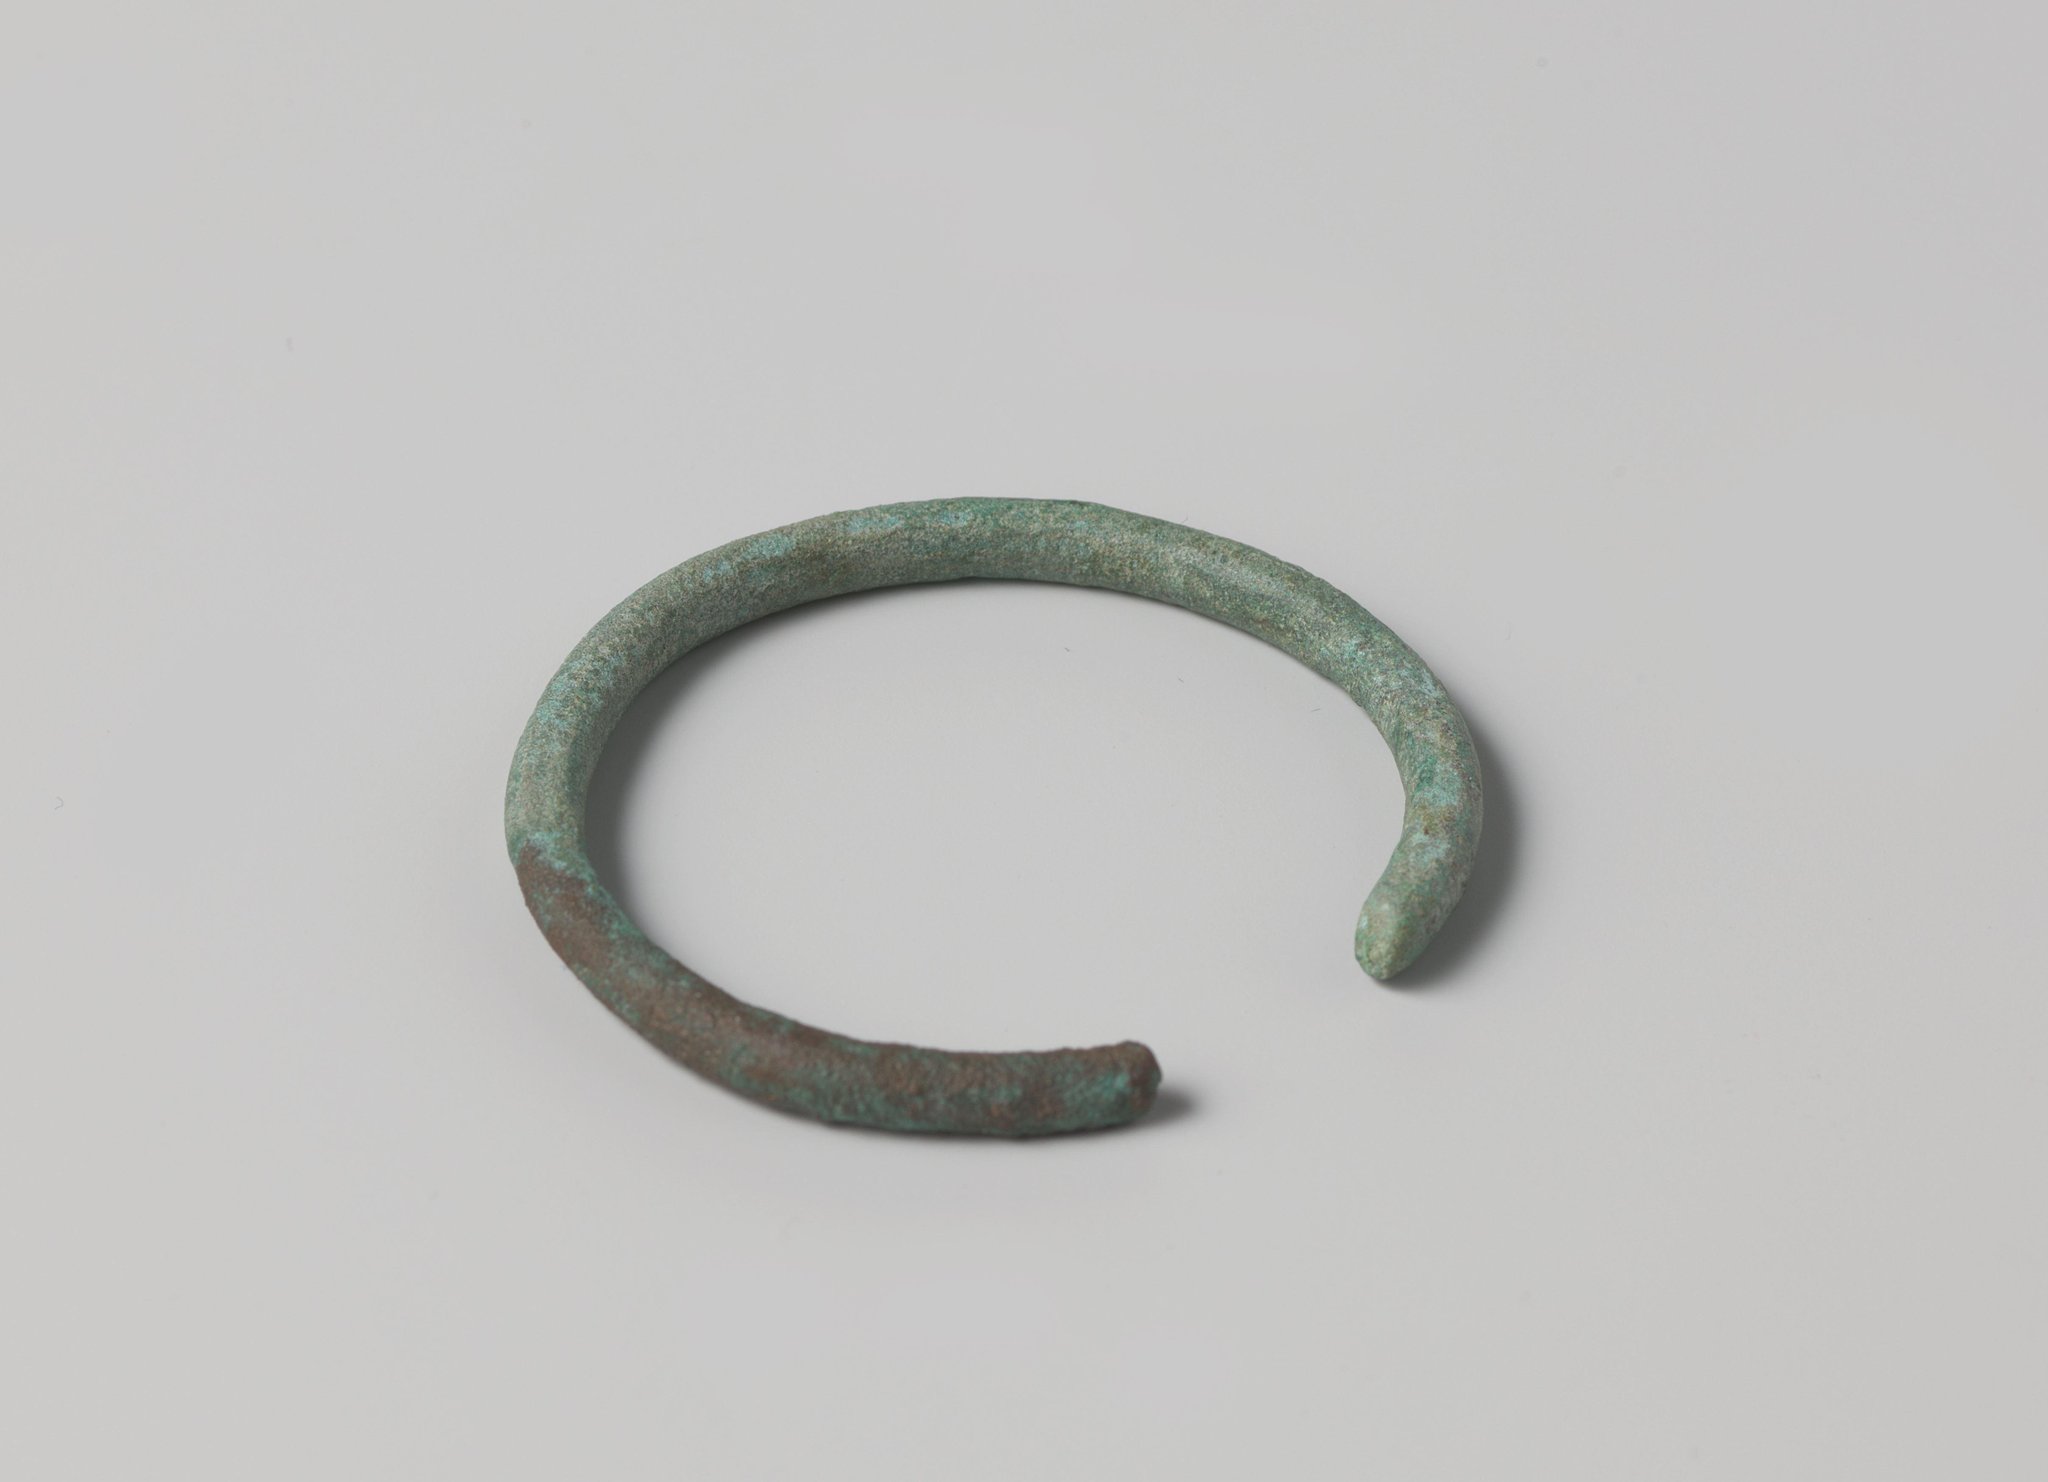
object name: bracelet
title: Armband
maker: Anonymous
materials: bronze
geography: ban chiang